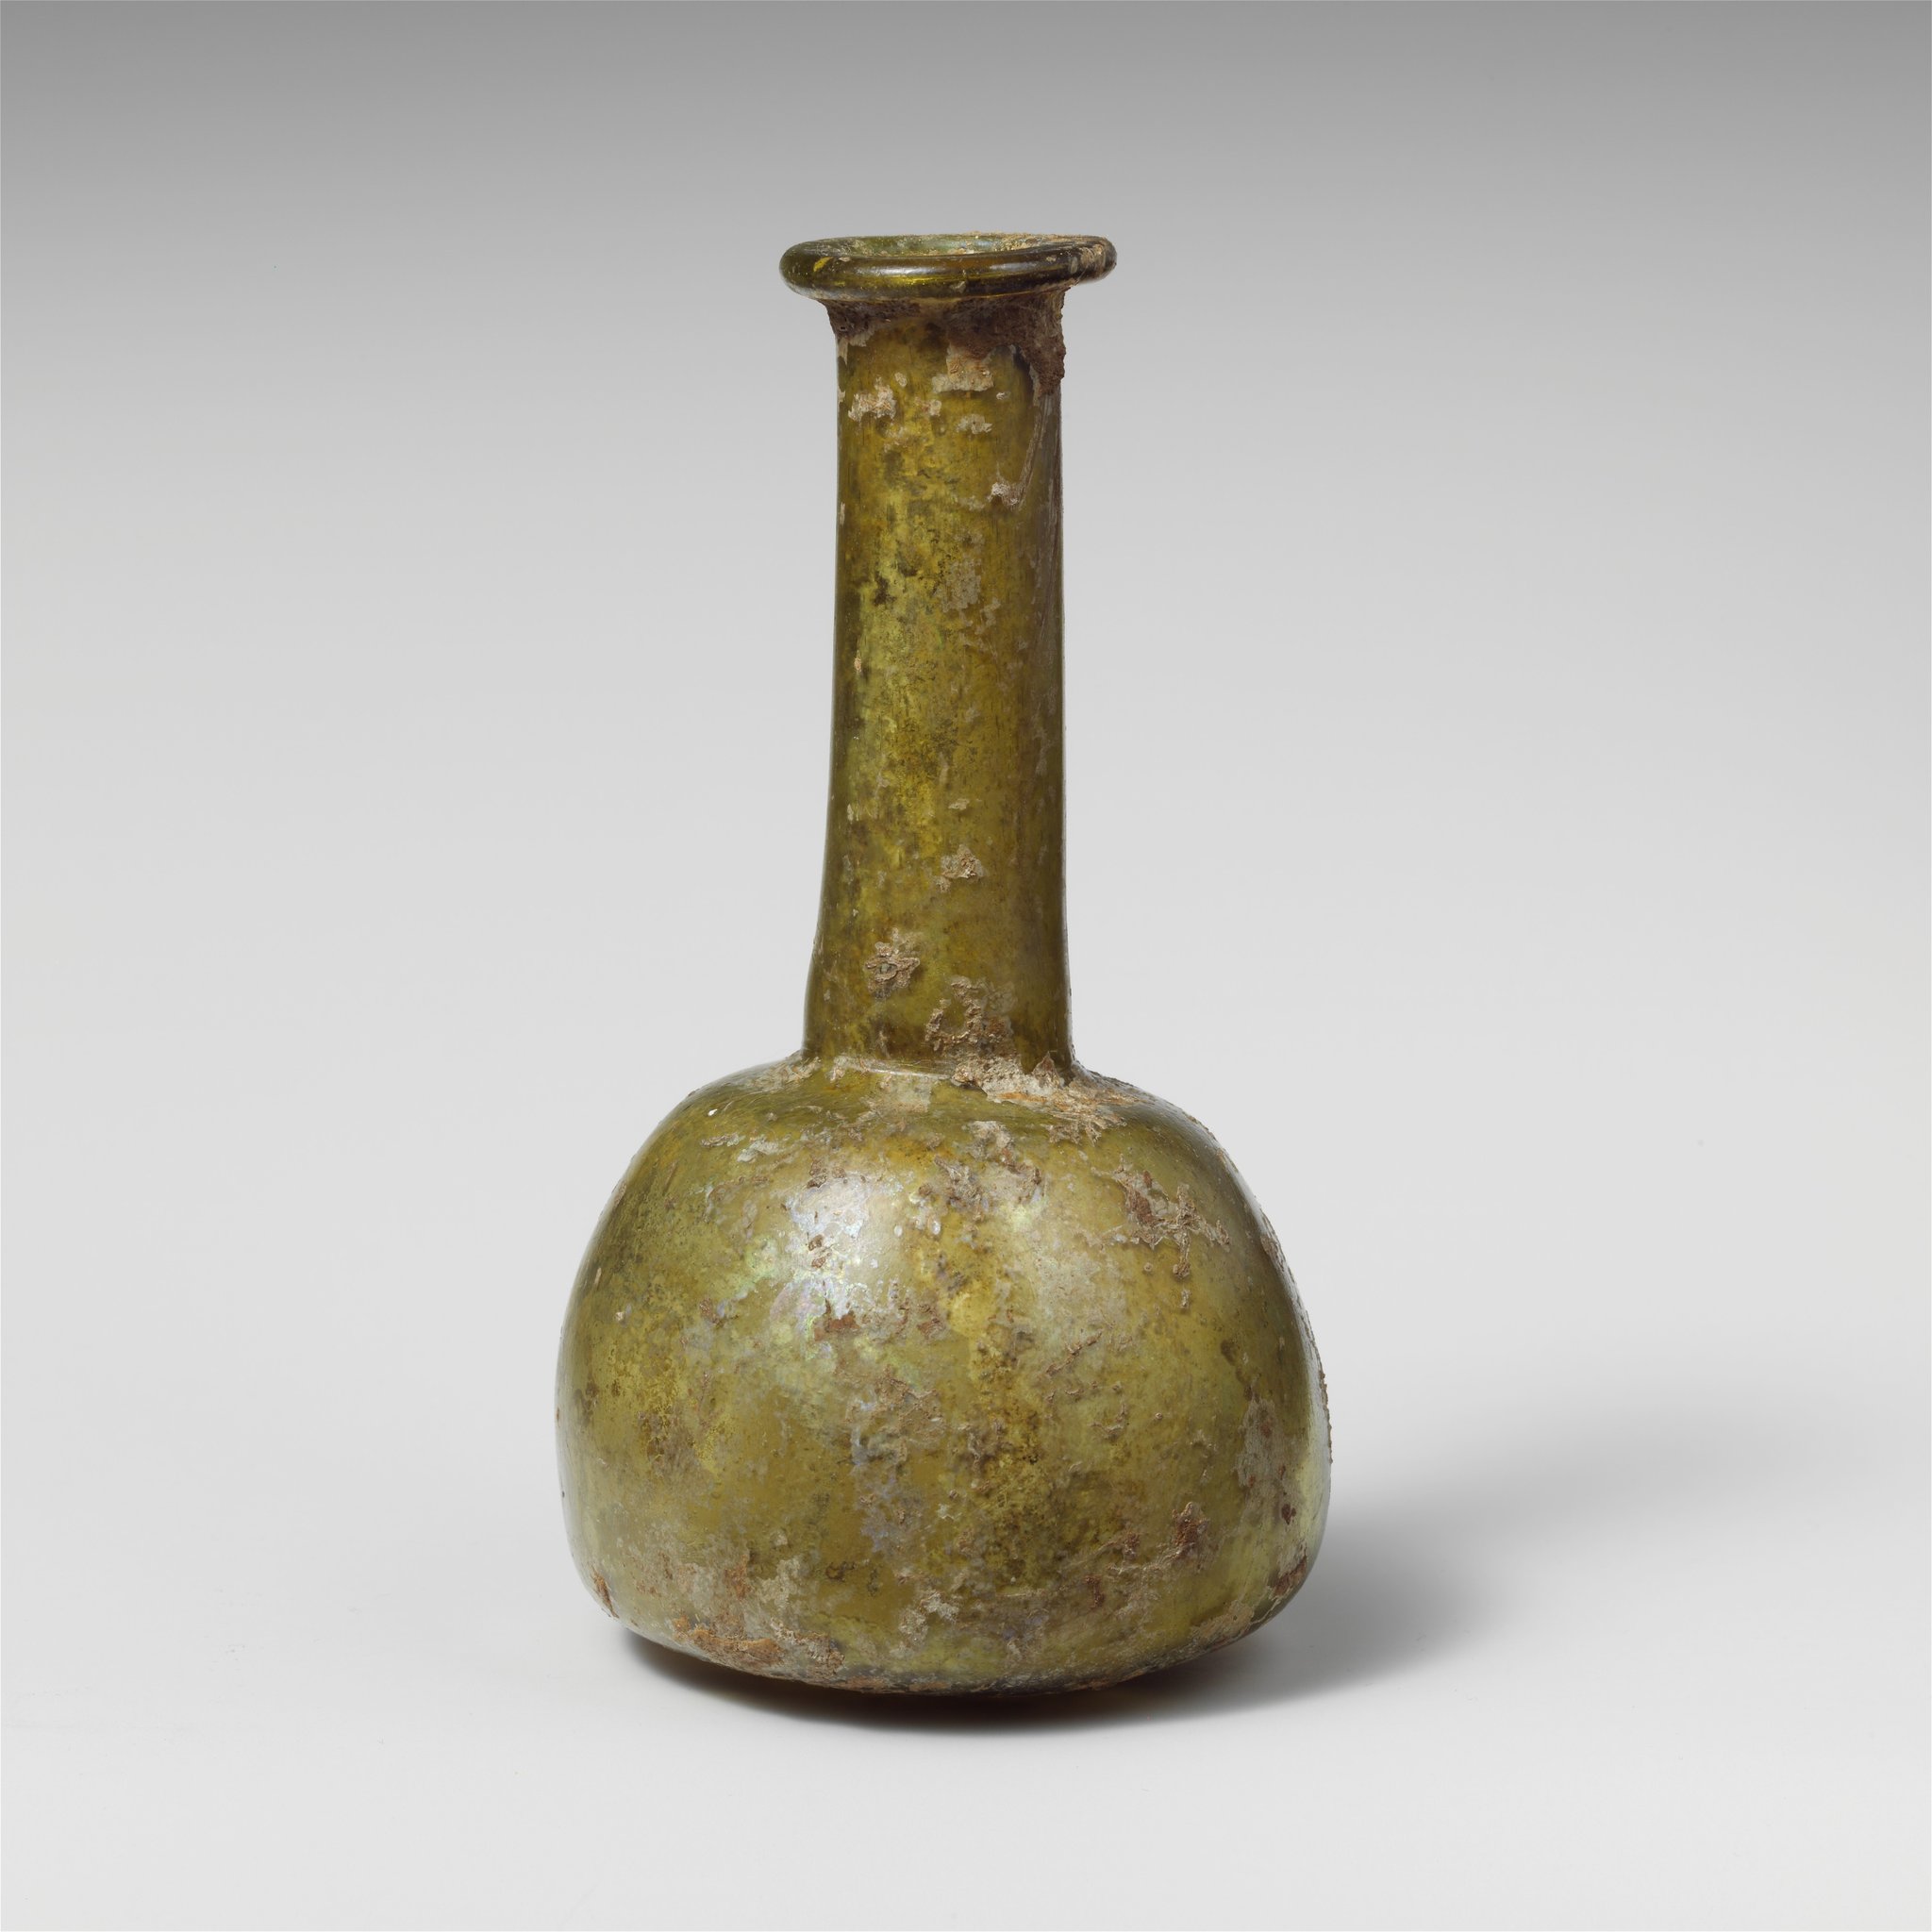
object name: perfume bottle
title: Glass perfume bottle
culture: roman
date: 101-300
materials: glass